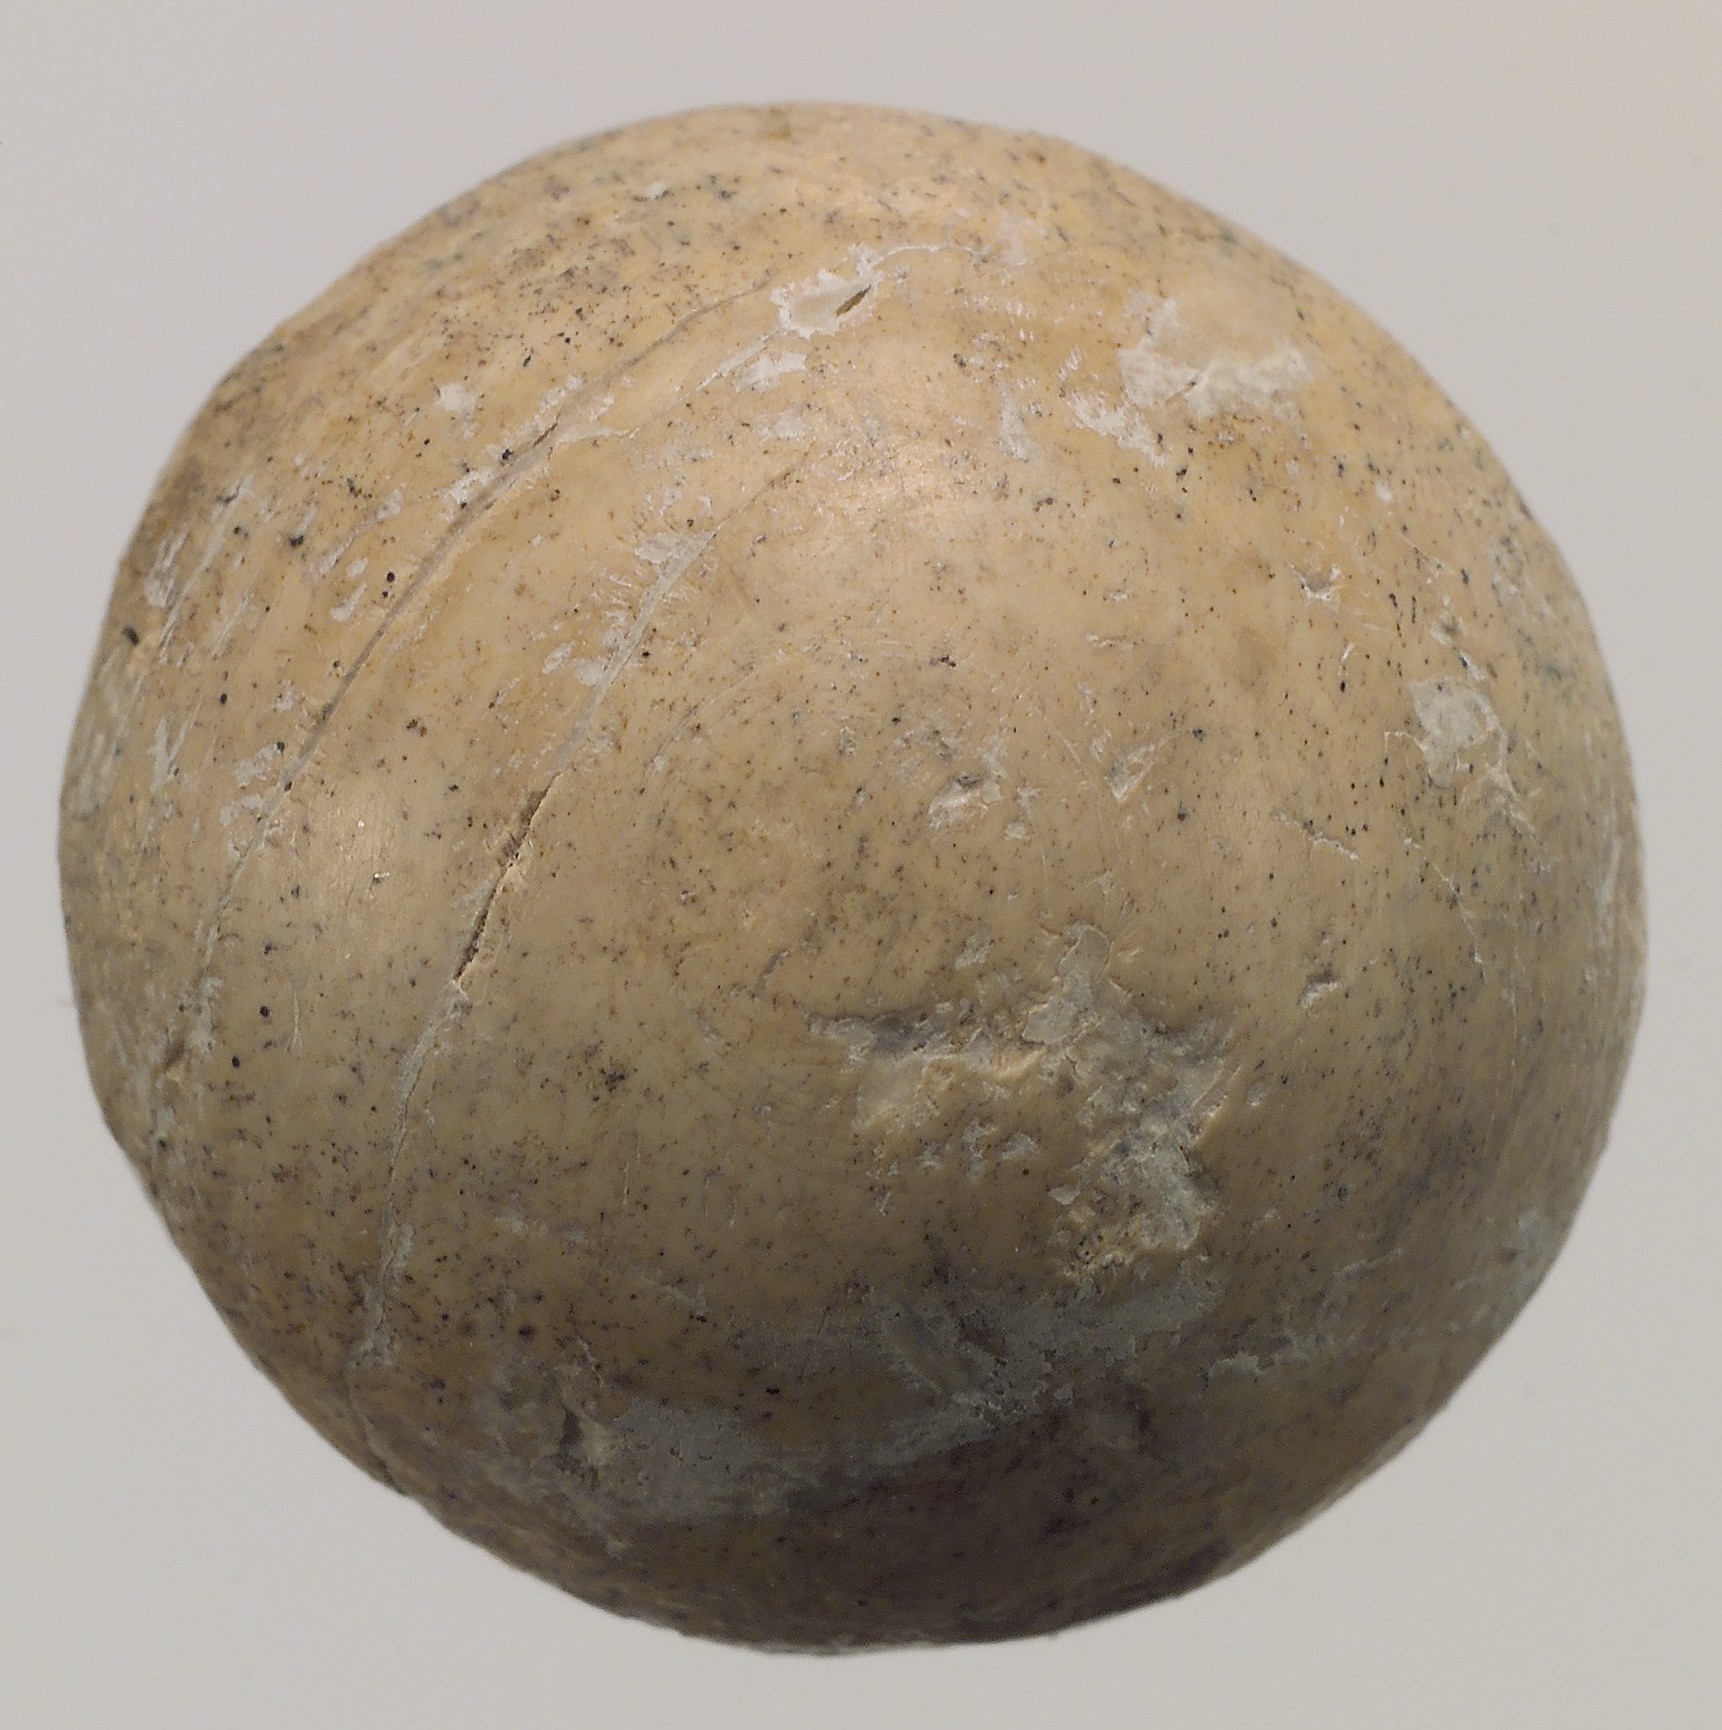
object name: knob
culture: assyrian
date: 800-701 BCE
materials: ivory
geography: mesopotamia